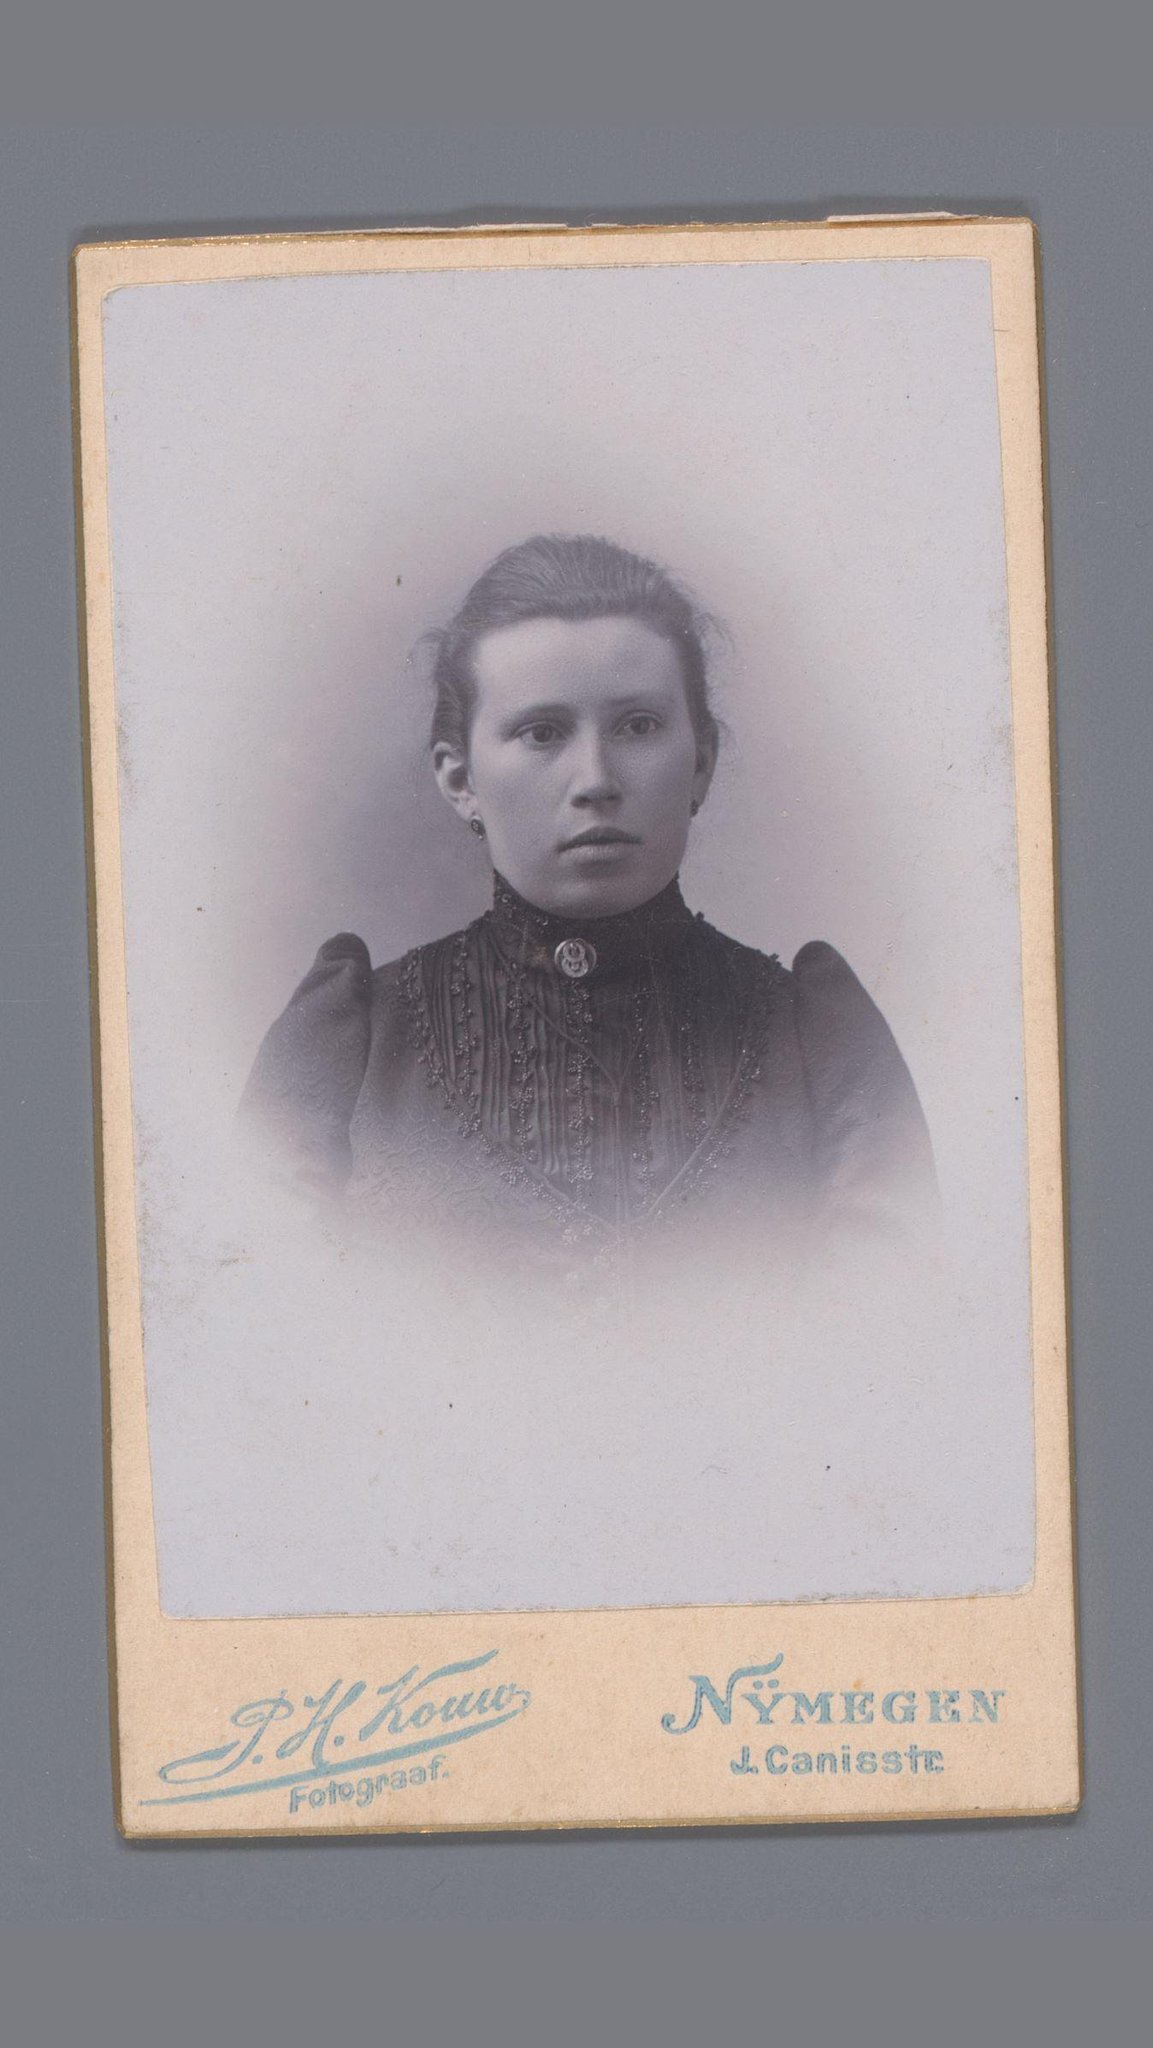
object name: carte de visite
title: Portret van een onbekende vrouw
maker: p.h. kouw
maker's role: fotograaf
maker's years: 1870-1942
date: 1903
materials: cardboard, photographic support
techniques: collodion silver print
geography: nijmegen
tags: historical persons - bb - woman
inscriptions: inscription: ‘ontvangen/ den 17 Februari/ 1903’, address: ‘P.H. Kouw/ Fotograaf./ NIJMEGEN/ J. Canisstr.’